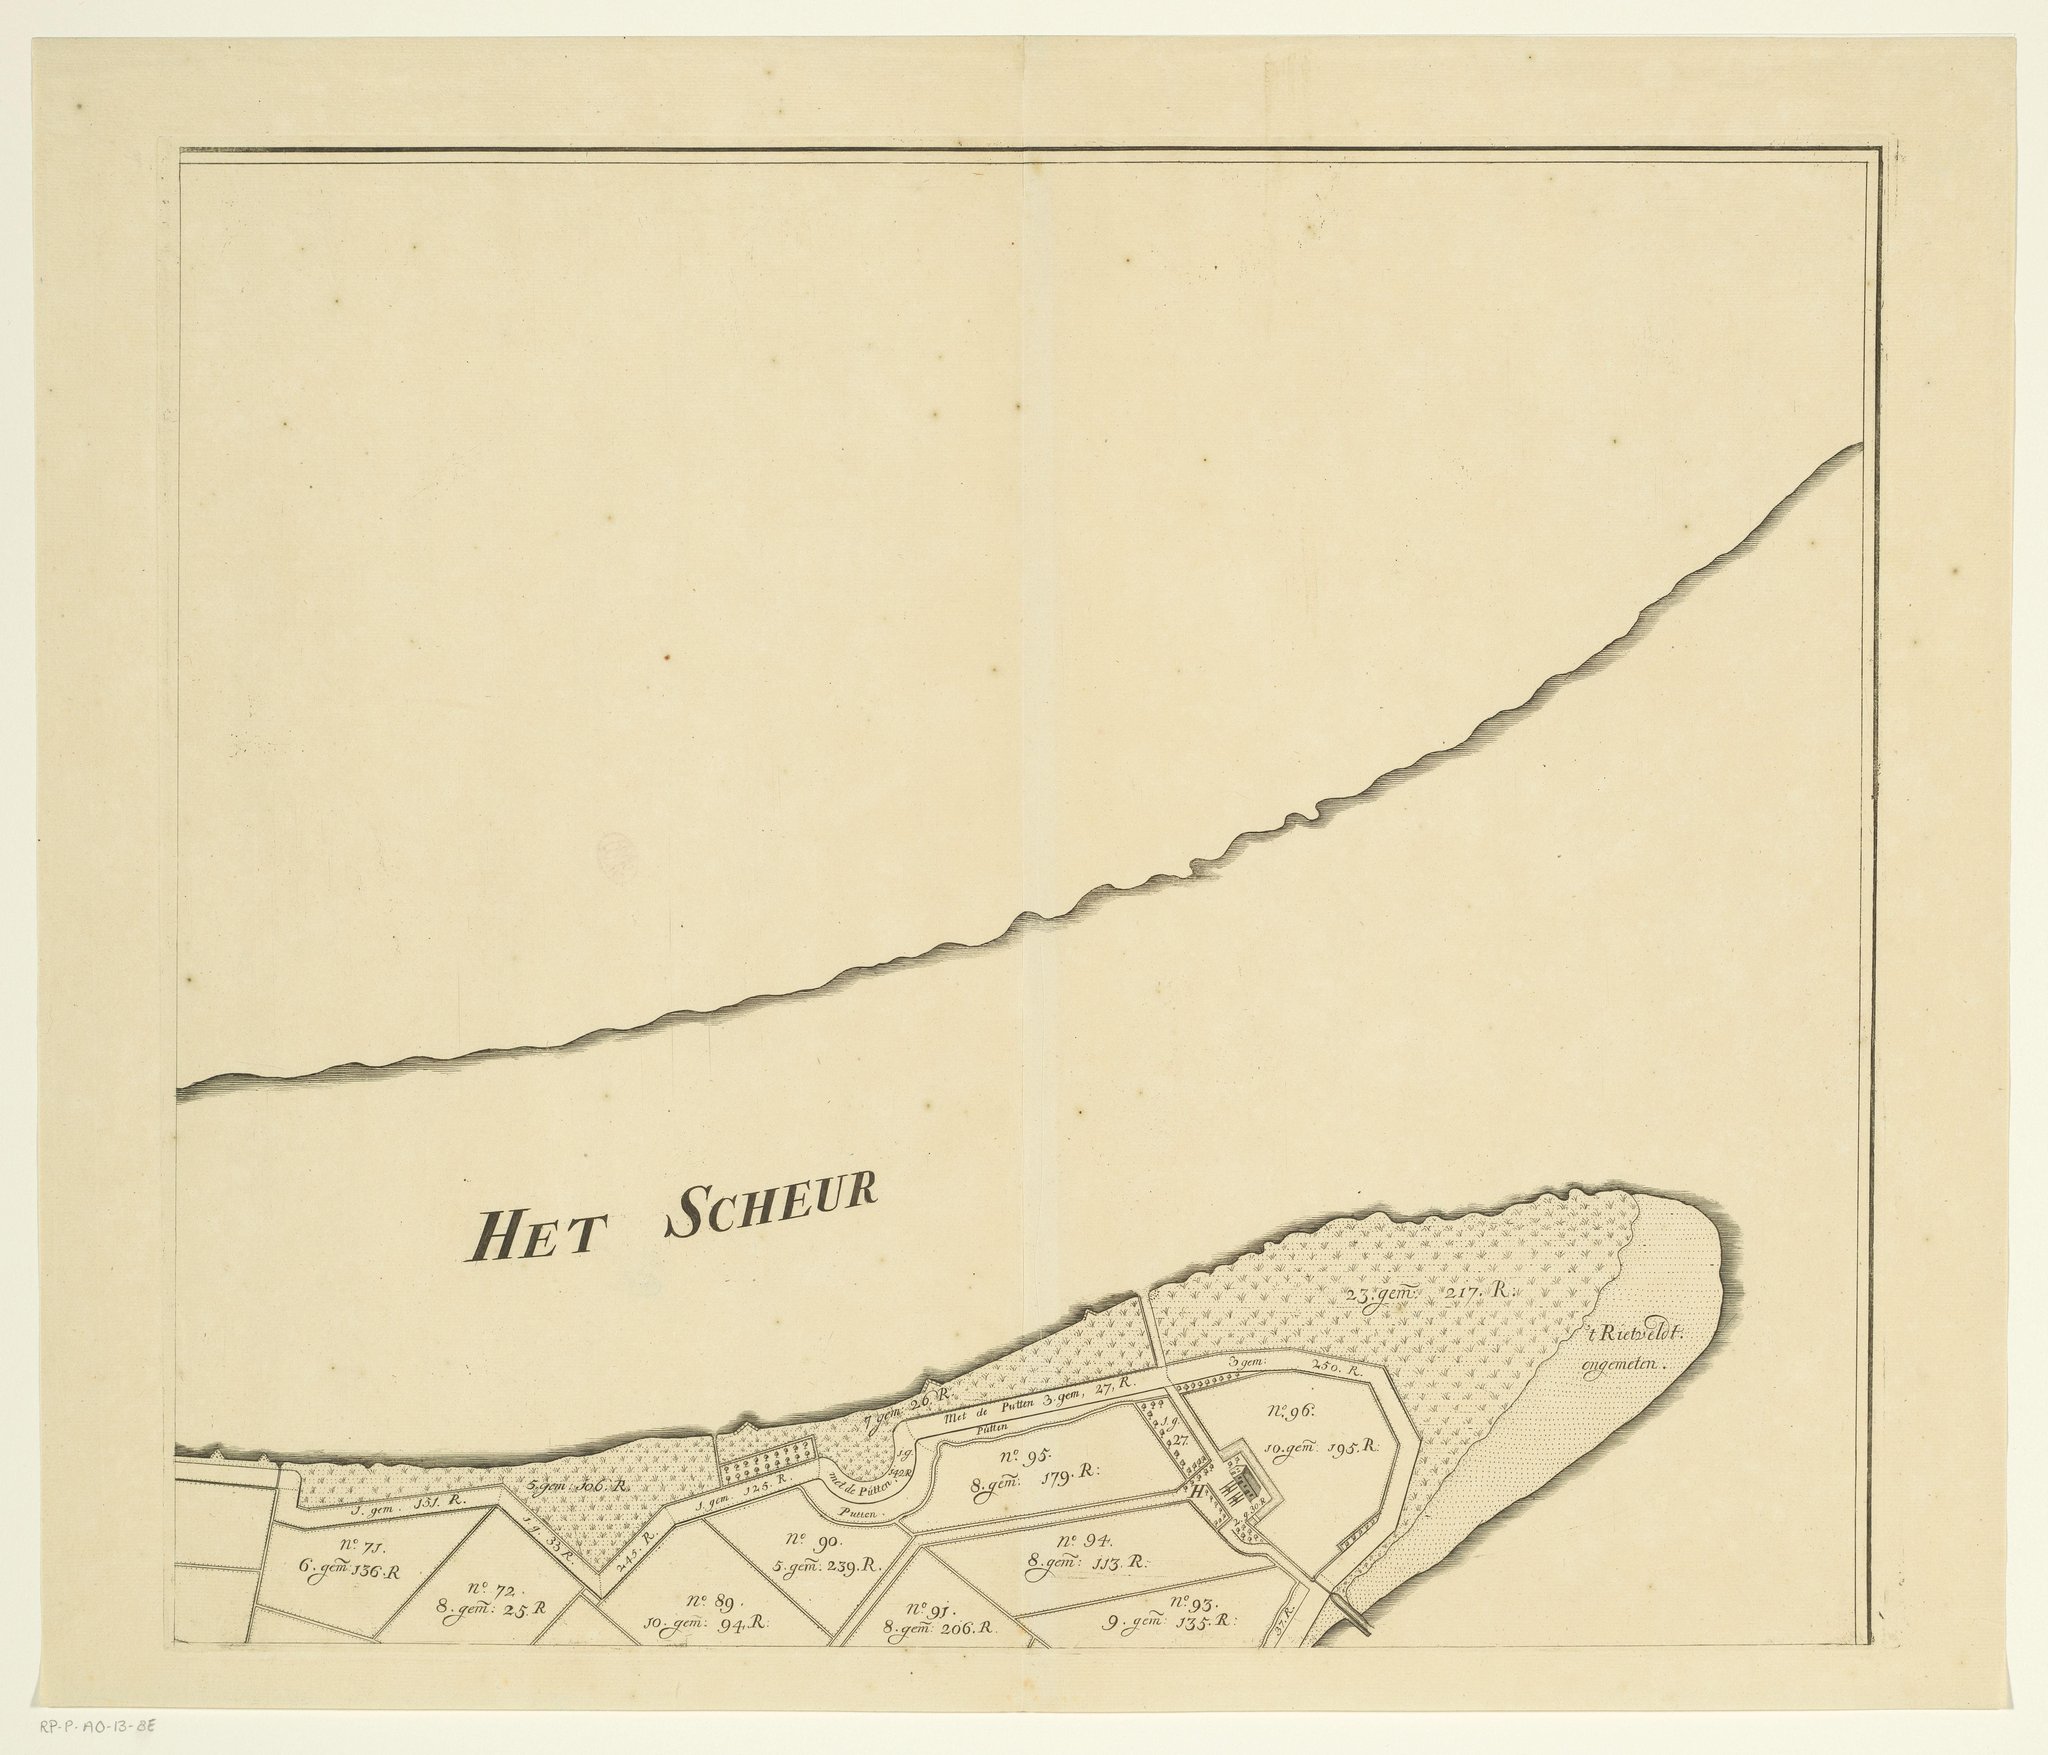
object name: print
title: Kaart van het eiland Rozenburg (vierde deel van boven)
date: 1727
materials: paper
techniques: engraving, etching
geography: the hague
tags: maps of separate countries or regions, polder, reclaimed land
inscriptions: collector's mark: Lugt 2228, collector's mark: Lugt 195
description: Deel (vierde van boven) van een kaart van het eiland Rozenburg, bestaande uit acht delen.